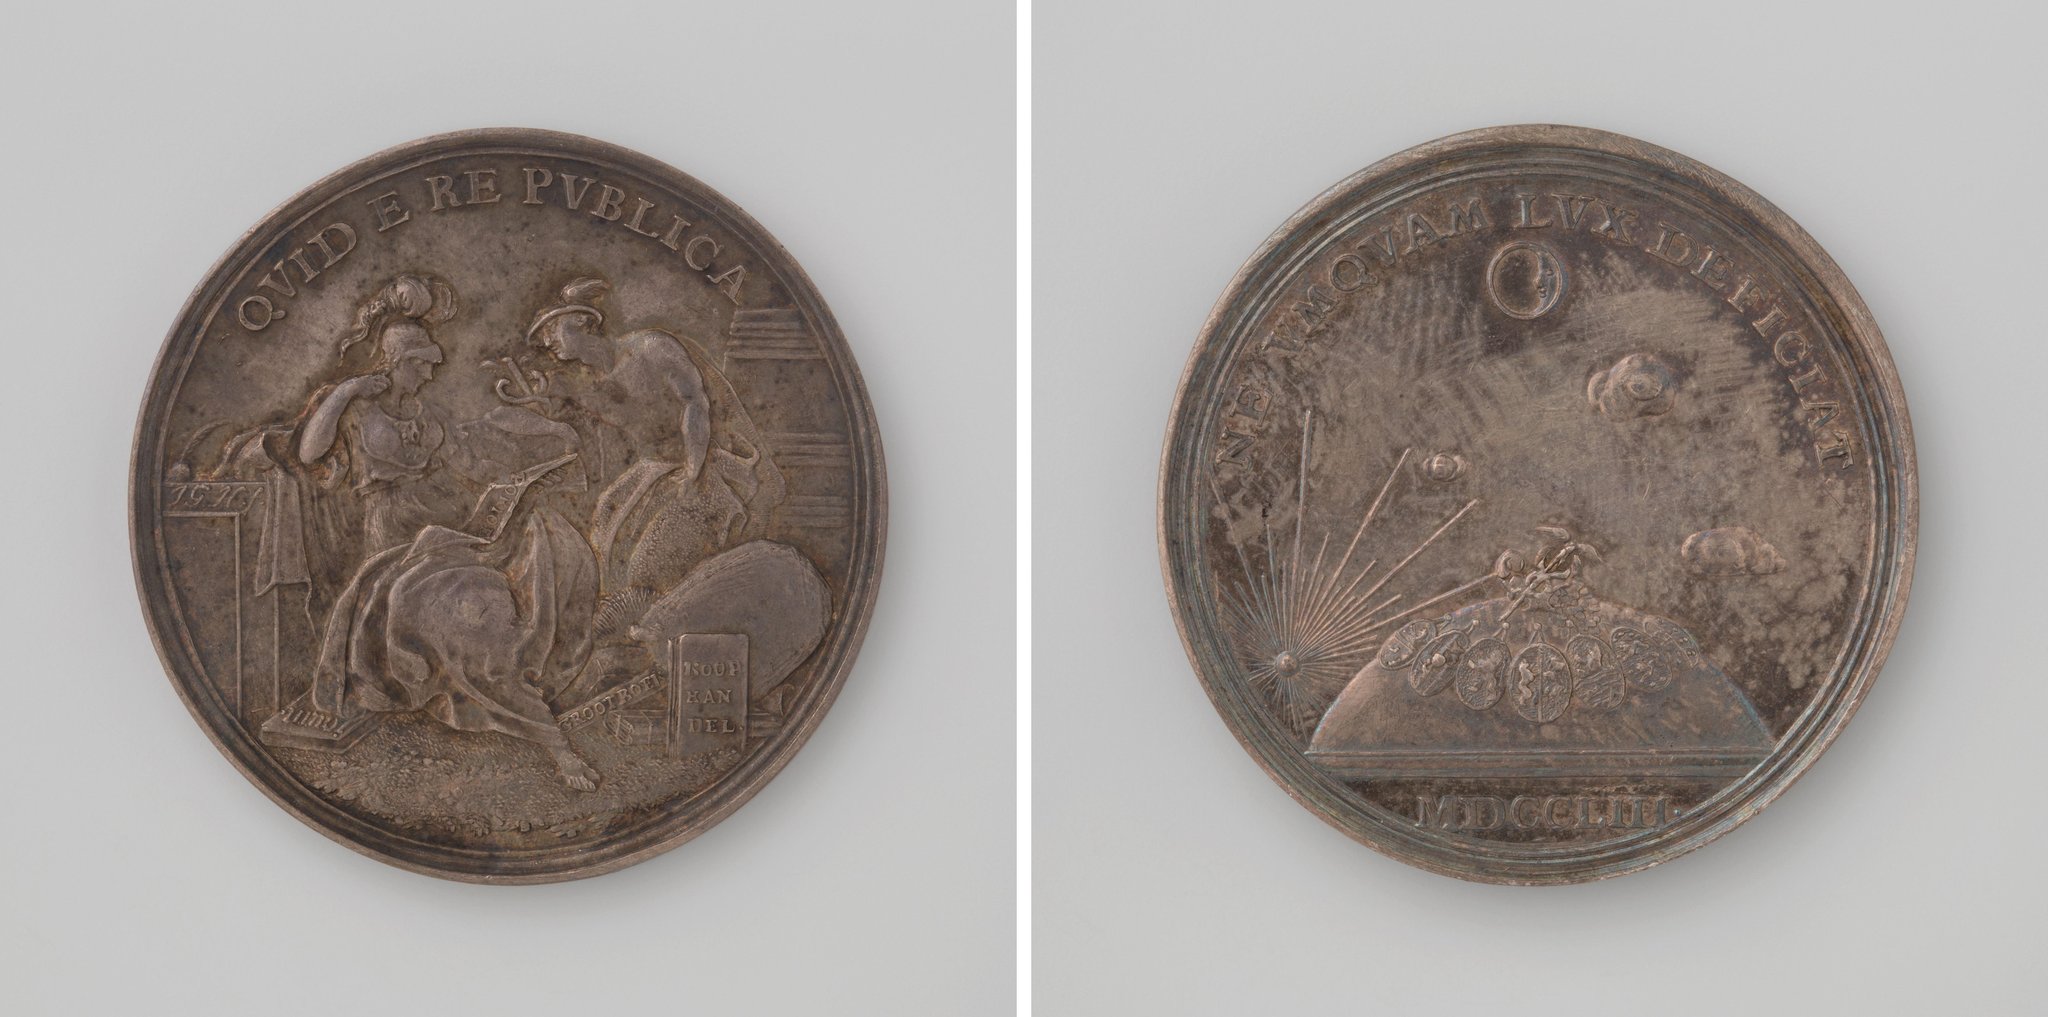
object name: new year medal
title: Aanvang van het jaar 1753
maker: johan george holtzhey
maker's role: mintmaster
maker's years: 1726-1808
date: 1753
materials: silver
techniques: striking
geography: amsterdam